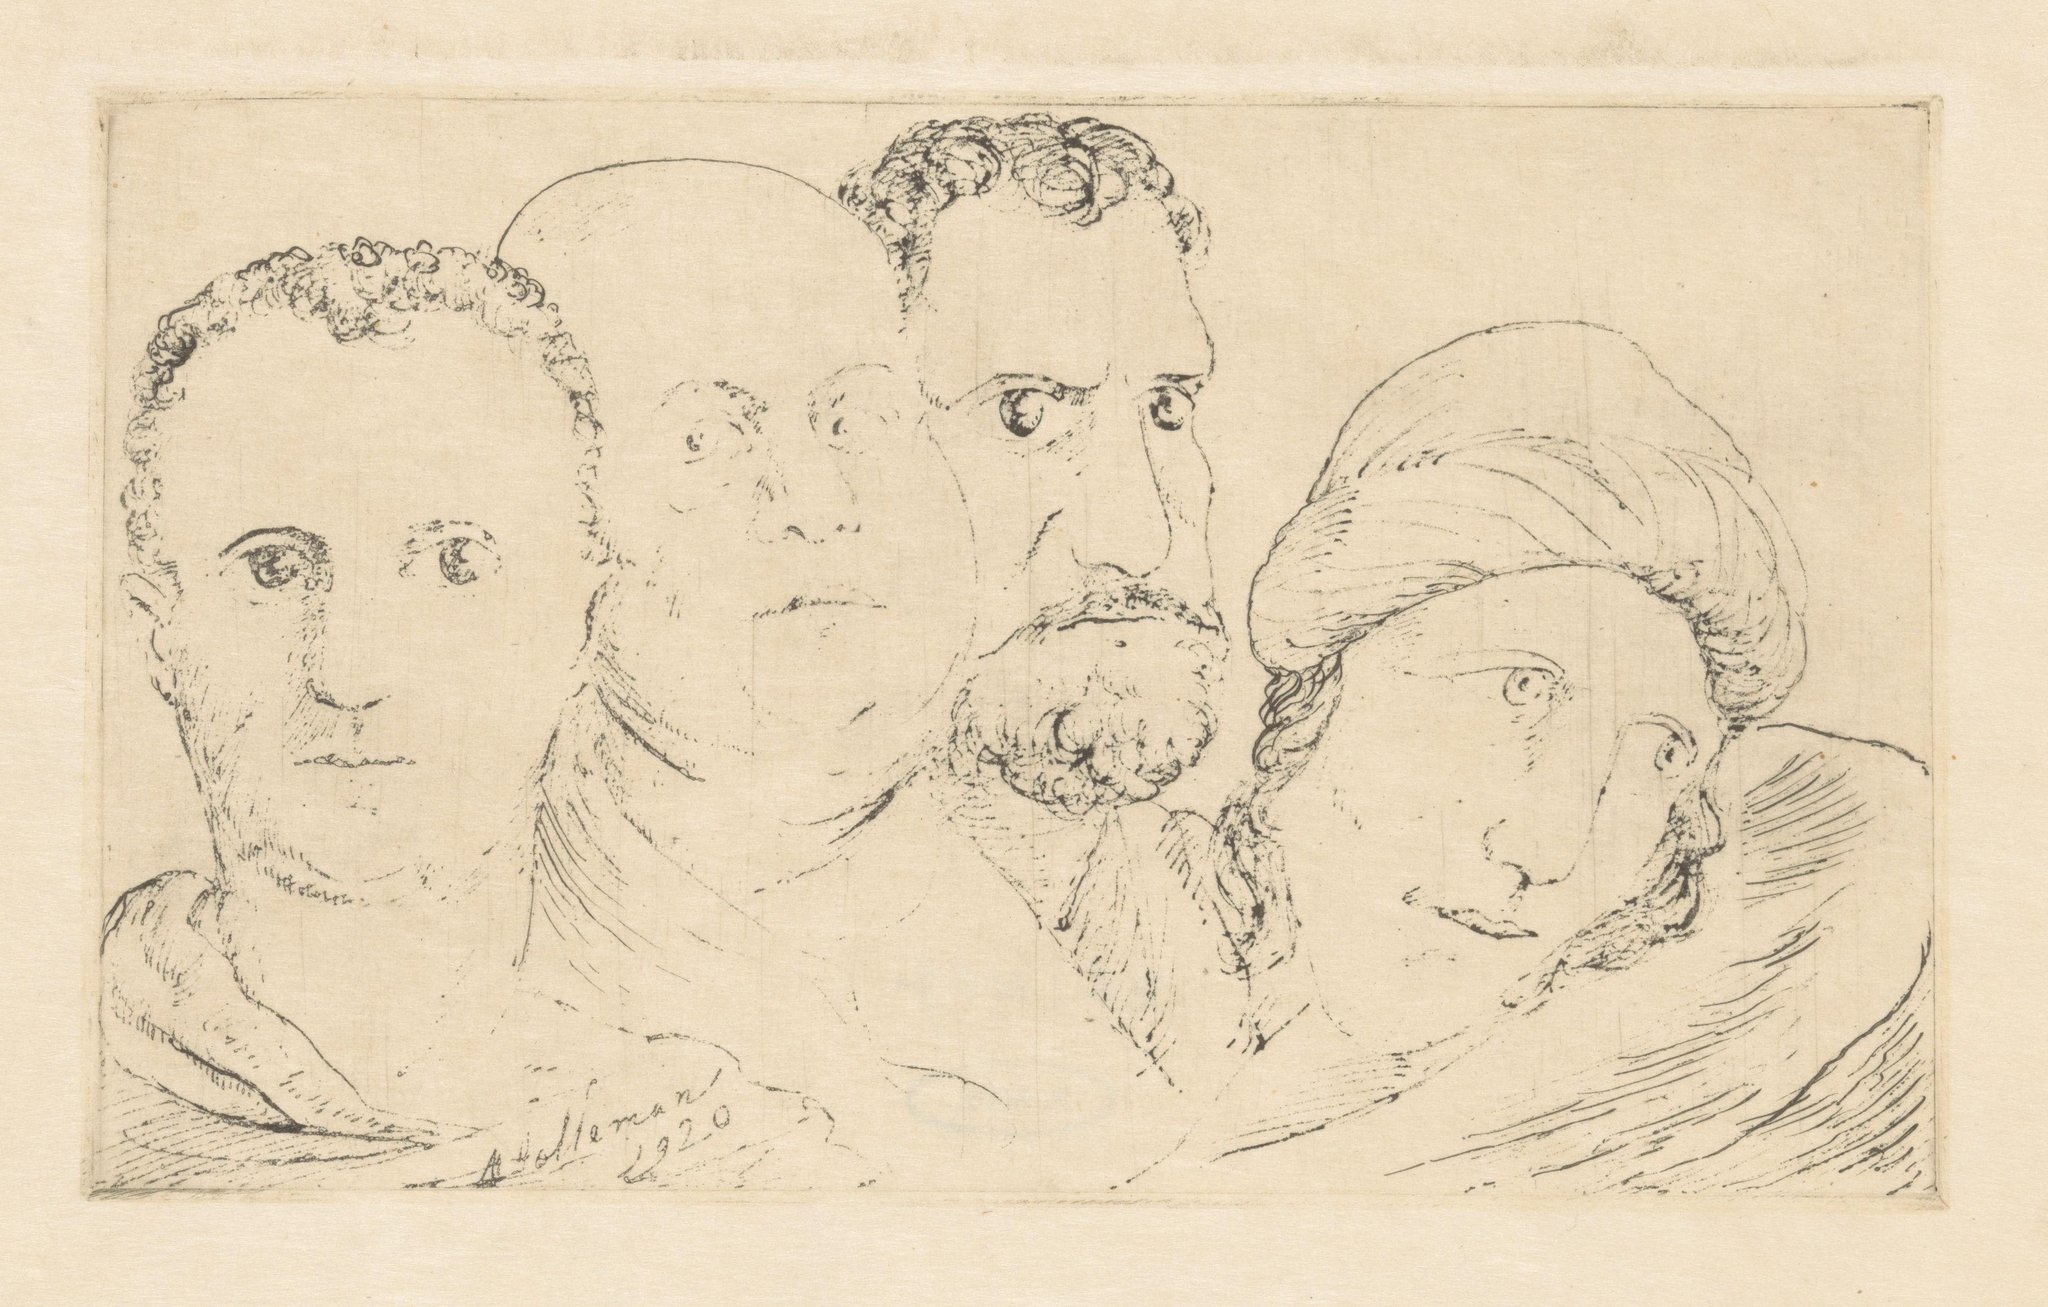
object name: print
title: Vrouw en drie mannen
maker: marius holleman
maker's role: draughtsman, print maker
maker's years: 1878-1926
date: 1920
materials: paper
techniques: etching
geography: groningen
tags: head-gear: hat, baldness, beard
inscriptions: collector's mark: Lugt 2228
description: Links een man met krullen, een kale man en een man met een baard. Links een vrouw met een muts.